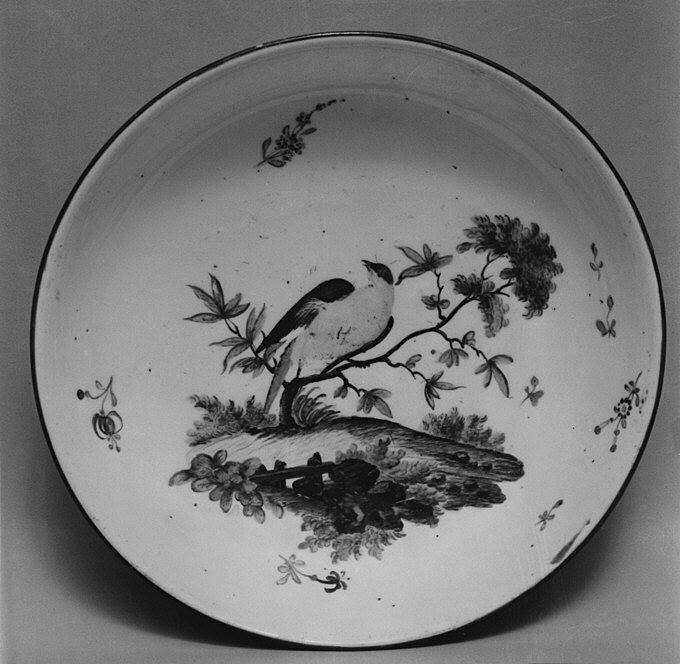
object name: saucer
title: Saucer (part of a service)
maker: frankenthal porcelain manufactory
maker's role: manufactory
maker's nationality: german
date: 1770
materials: hard paste porcelain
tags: birds,flowers,trees